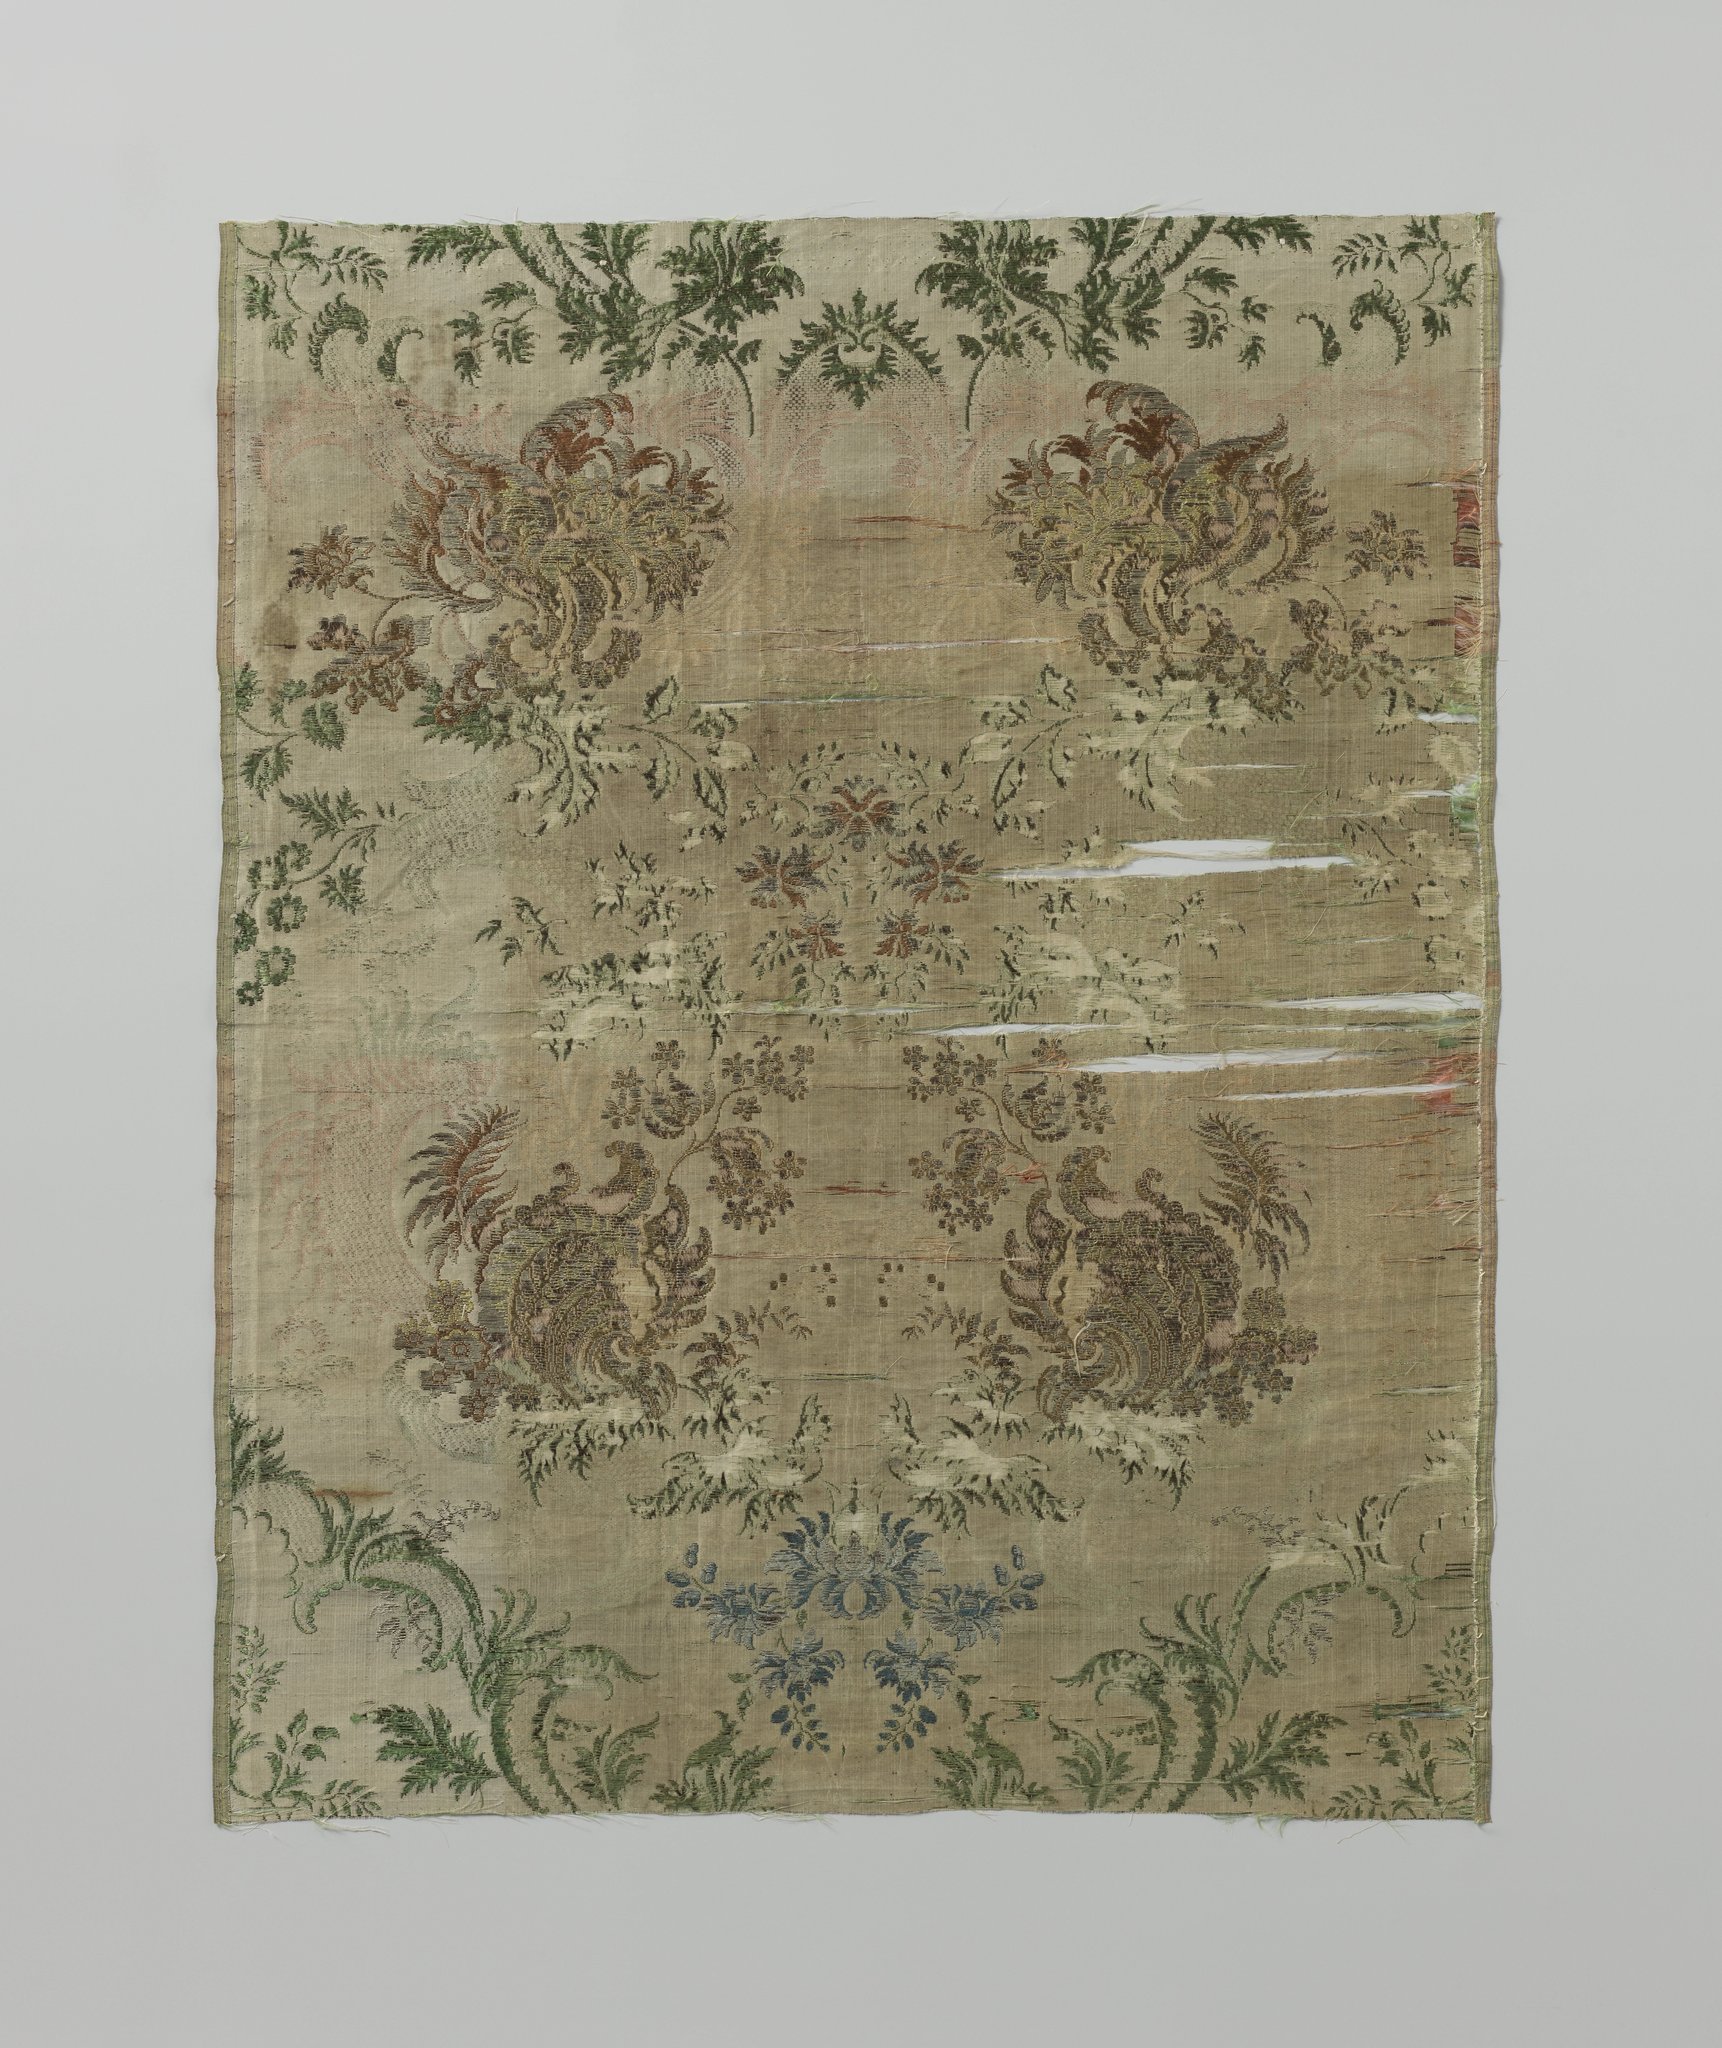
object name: fragment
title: Fragment veelkleurig zijdelampas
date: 1740-1760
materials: silk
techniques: brocade, lampas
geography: netherlands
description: Fragment veelkleurig zijdeweefsel. Op een witte grond vormen acanthusbladeren, fijne bladeren en bloemtakken medaillons.